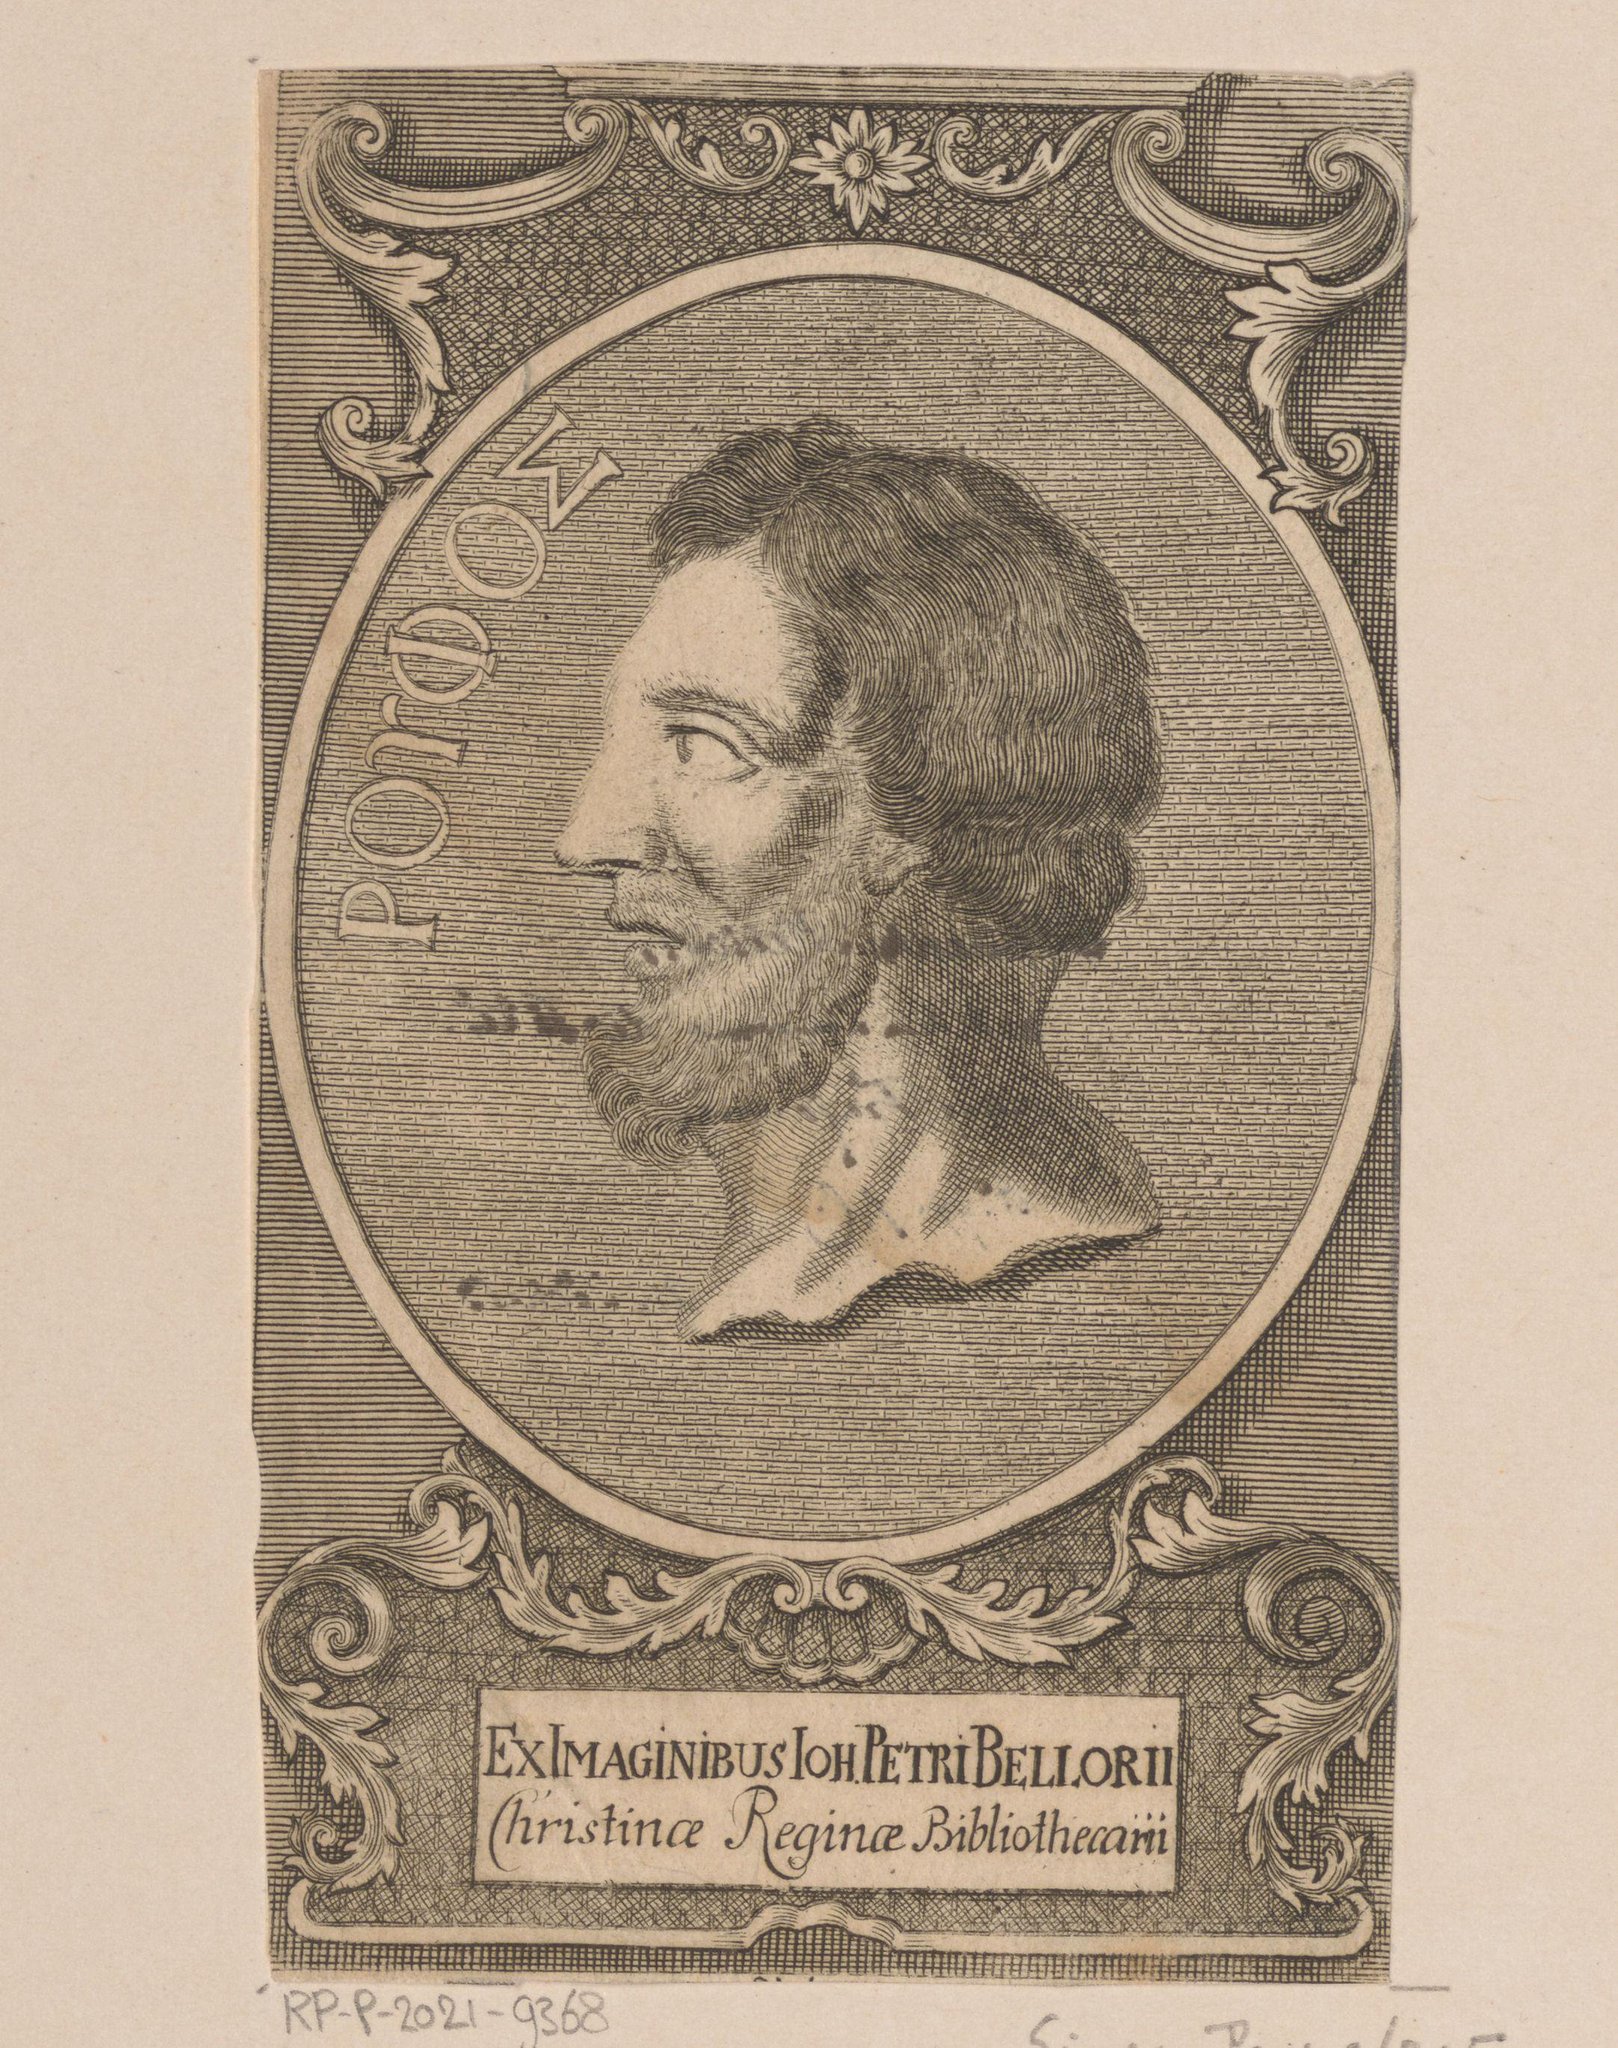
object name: print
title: Portret van Rufus van Efeze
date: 1750-1799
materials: paper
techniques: engraving, etching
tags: historical persons, physician, doctor